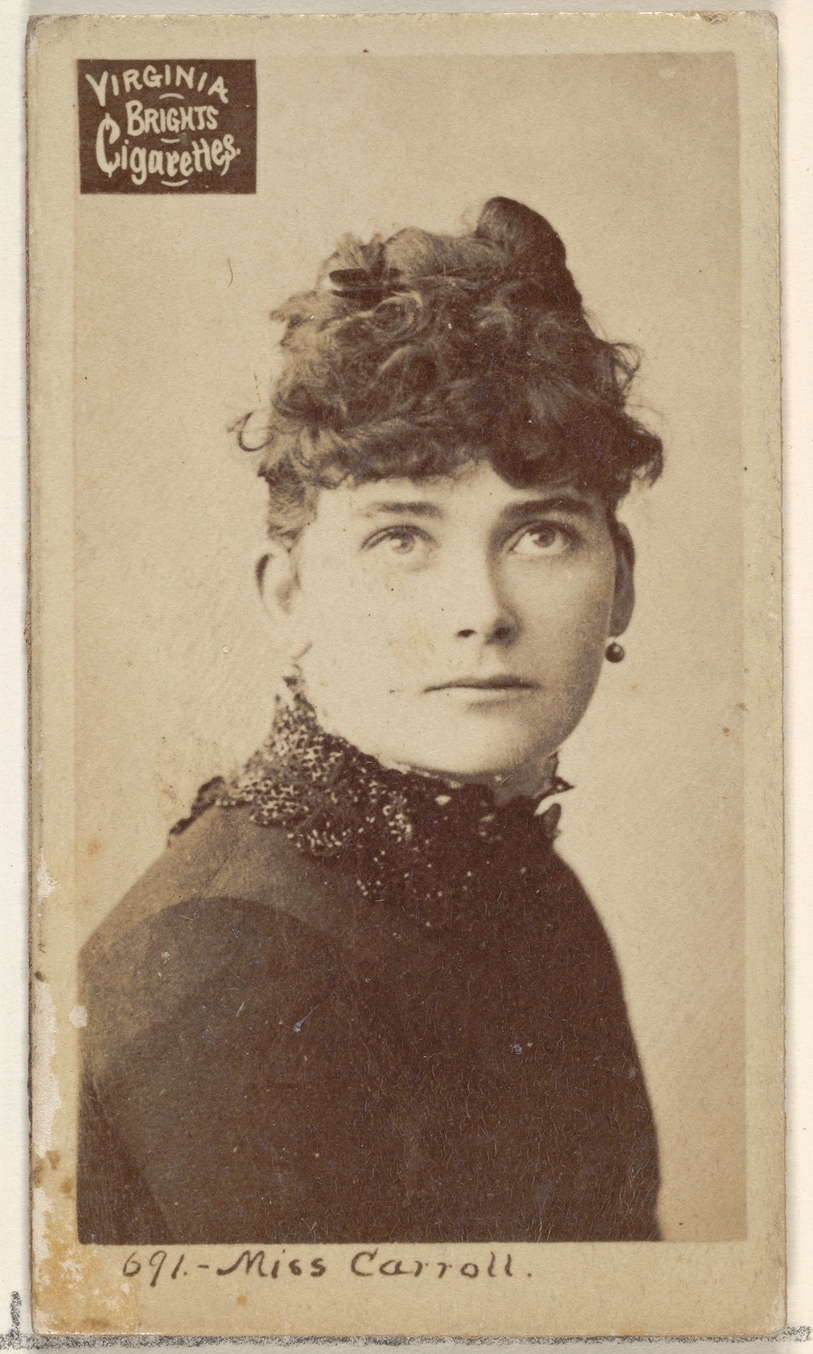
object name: photograph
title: Card 691, Miss Carroll, from the Actors and Actresses series (N45, Type 2) for Virginia Brights Cigarettes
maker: allen & ginter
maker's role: publisher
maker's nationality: american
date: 1888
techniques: albumen silver print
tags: portraits,women,actresses